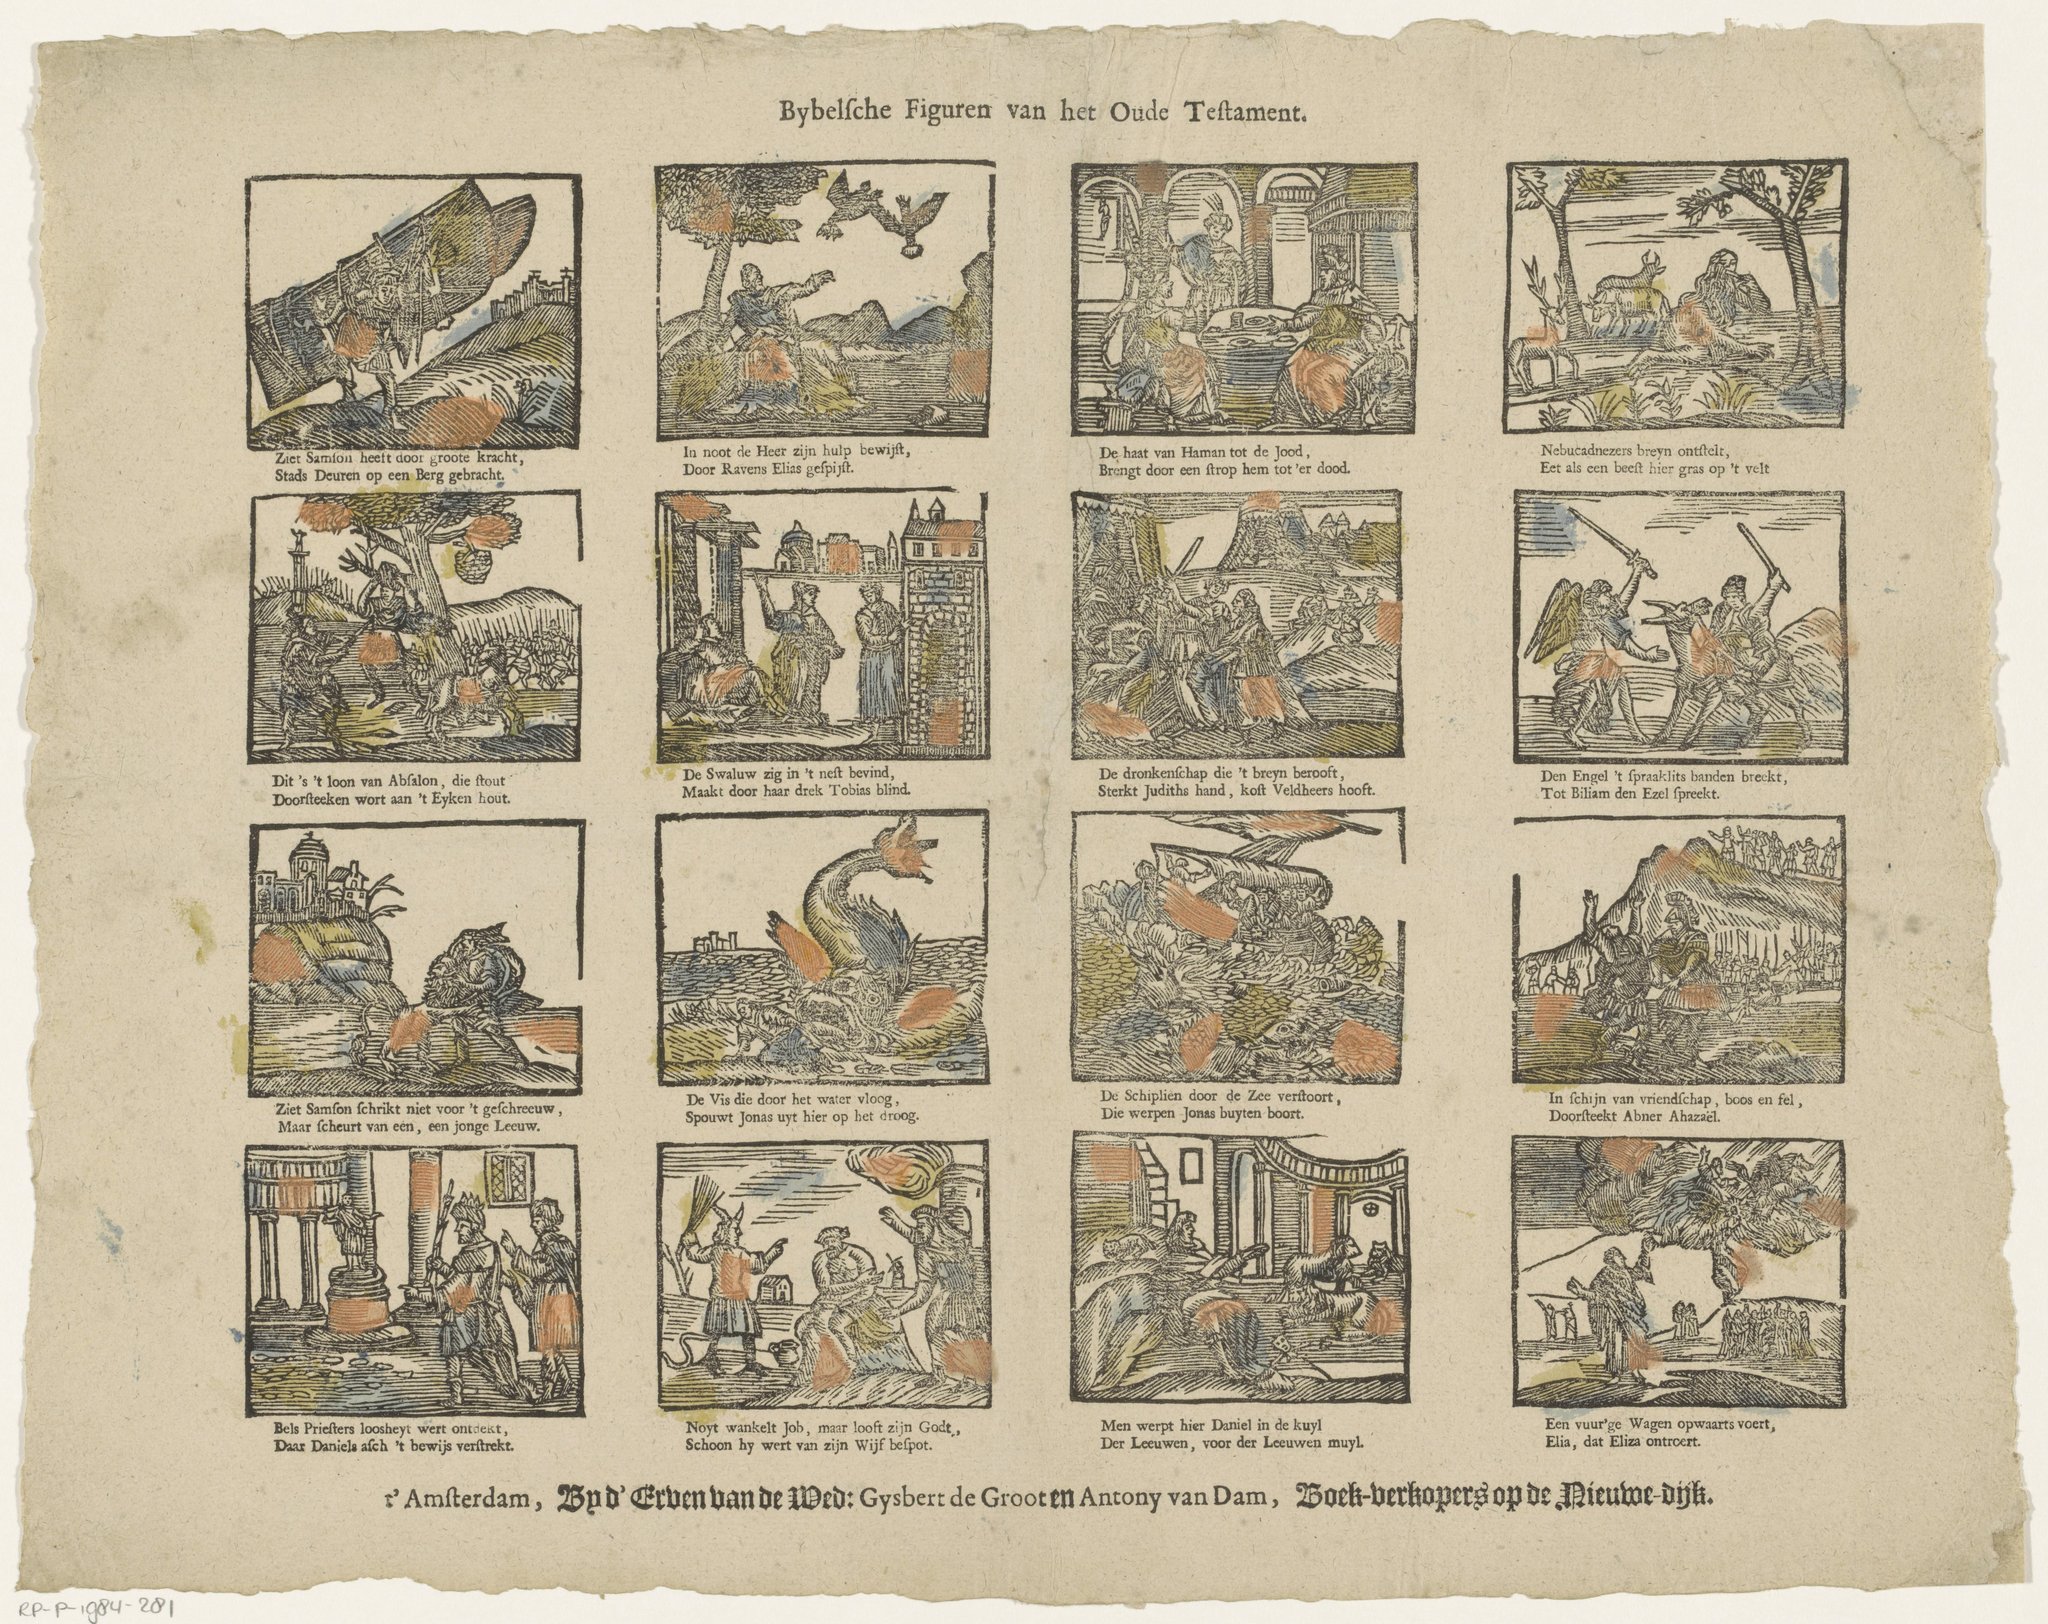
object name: print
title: Bijbelsche figuren van het Oude Testament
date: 1719-1724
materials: paper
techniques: colour, letterpress printing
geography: amsterdam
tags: samson carries the doors on his shoulders to the top of a hill near hebron, a bird dropping falls in tobit's eyes, after a three-day sojourn in the belly of the monster jonah is cast on dry land; jonah may be shown nude and bald-headed, old testament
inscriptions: collector's mark: Lugt 2760, collector's mark: Lugt 2228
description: Blad met 16 voorstellingen van verhalen uit het Oude Testament, zoals Simson die de stadspoort van Gaza een bergtop op sleept, Tobit die blind wordt door de poep van een zwaluw en Jona die uit de vis wordt gespuugd. Onder elke afbeelding een tweeregelig vers.